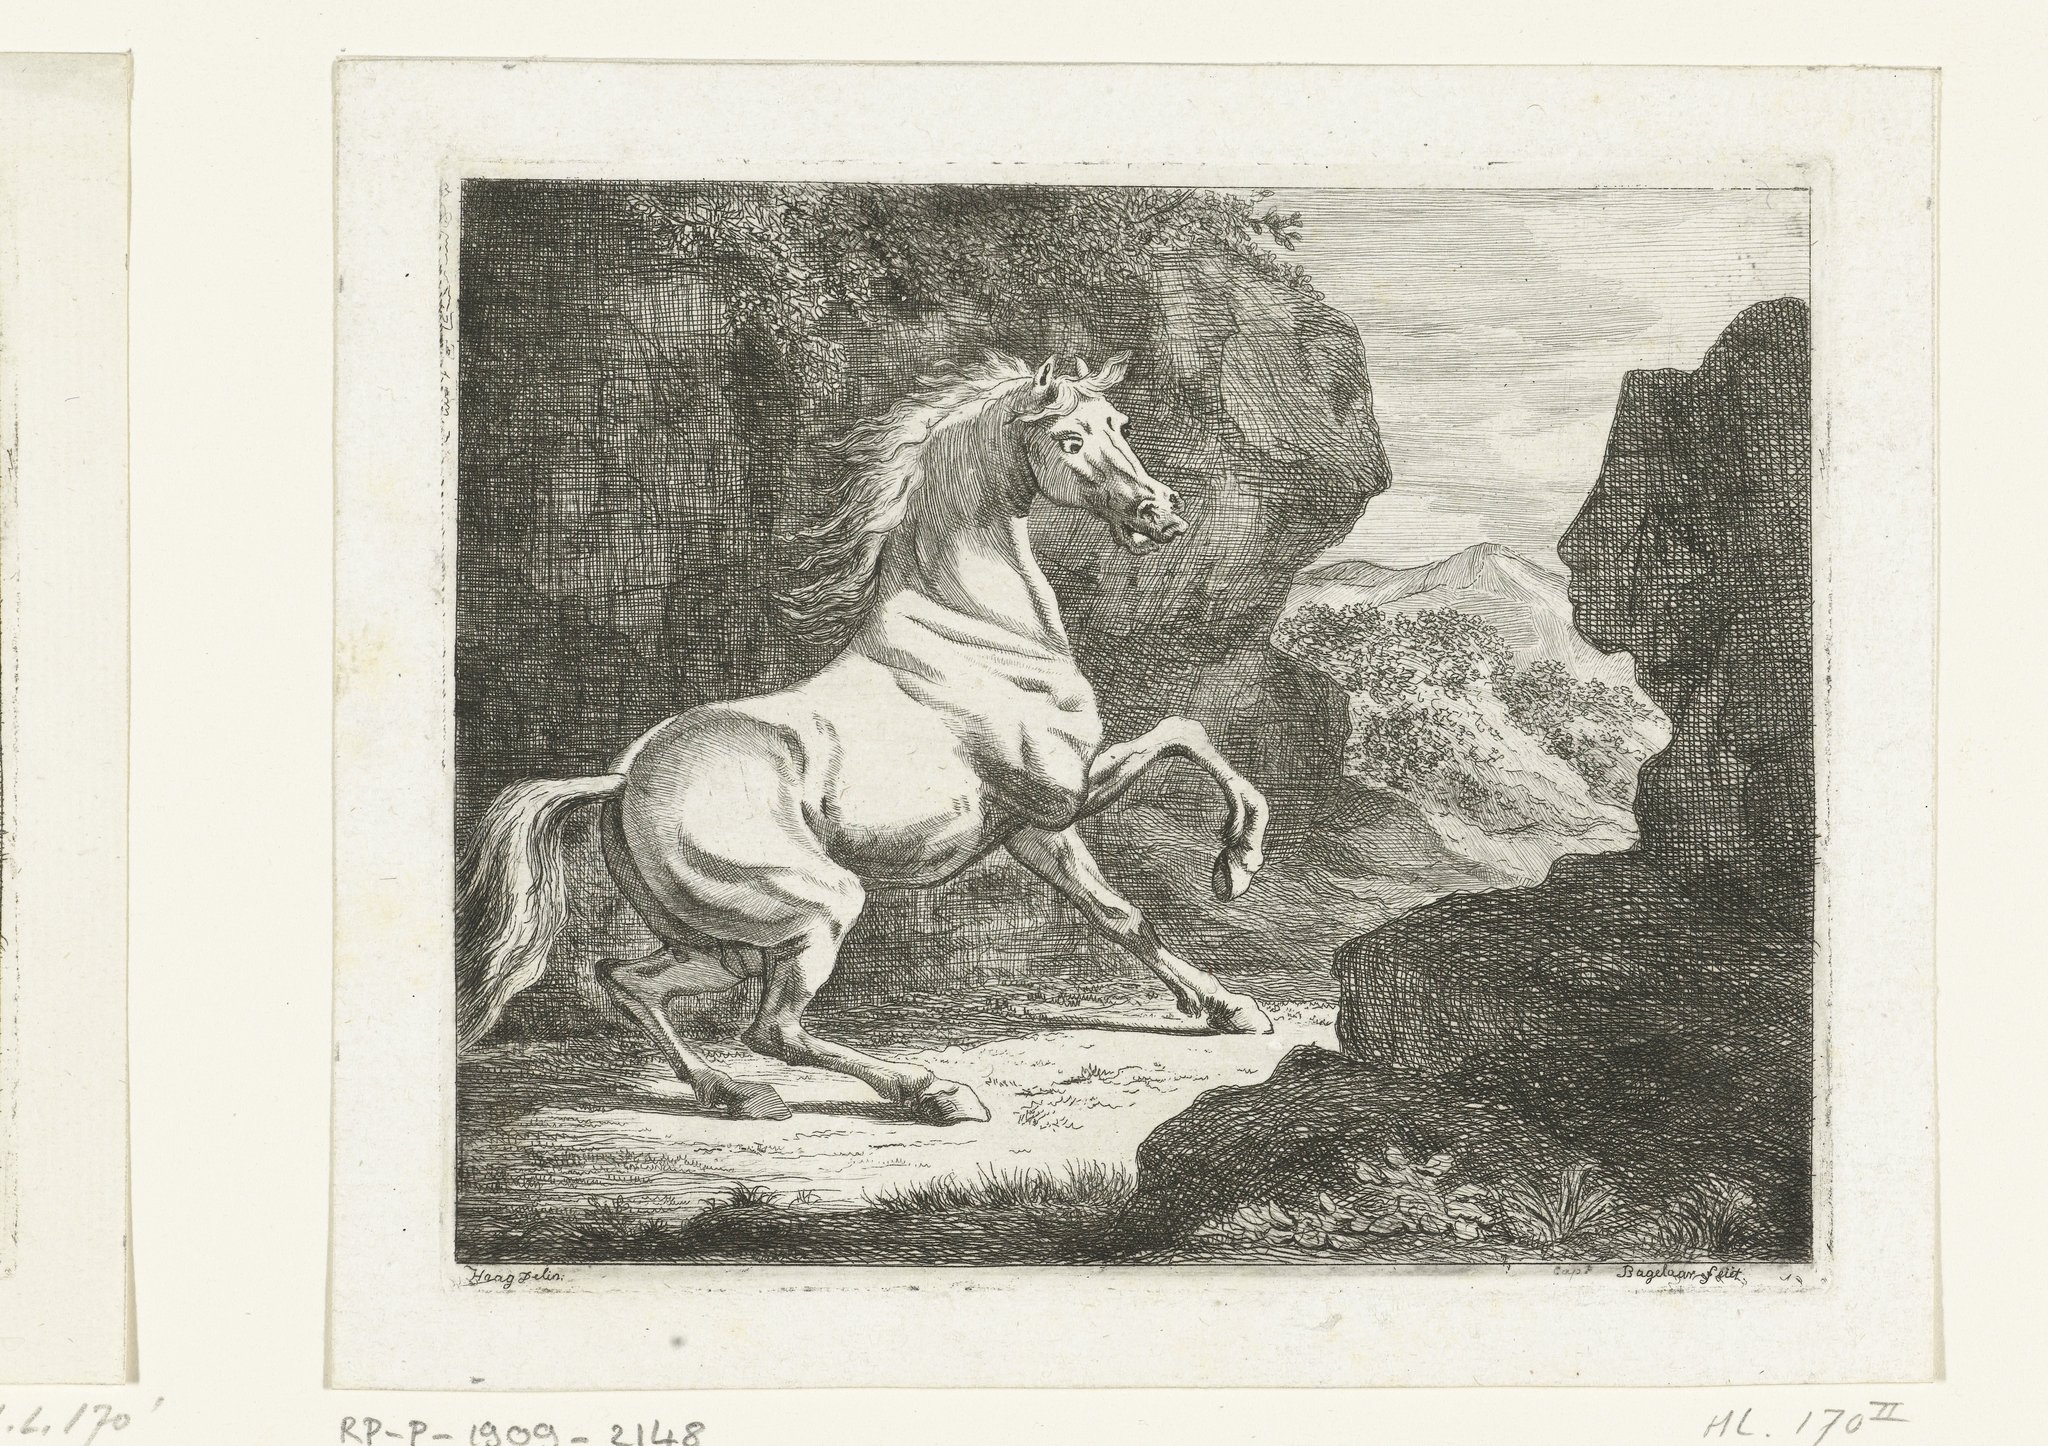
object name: print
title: Stuiterende witte hengst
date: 1798-1837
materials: paper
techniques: drypoint, etching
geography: netherlands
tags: horse in motion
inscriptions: collector's mark: Lugt 2228